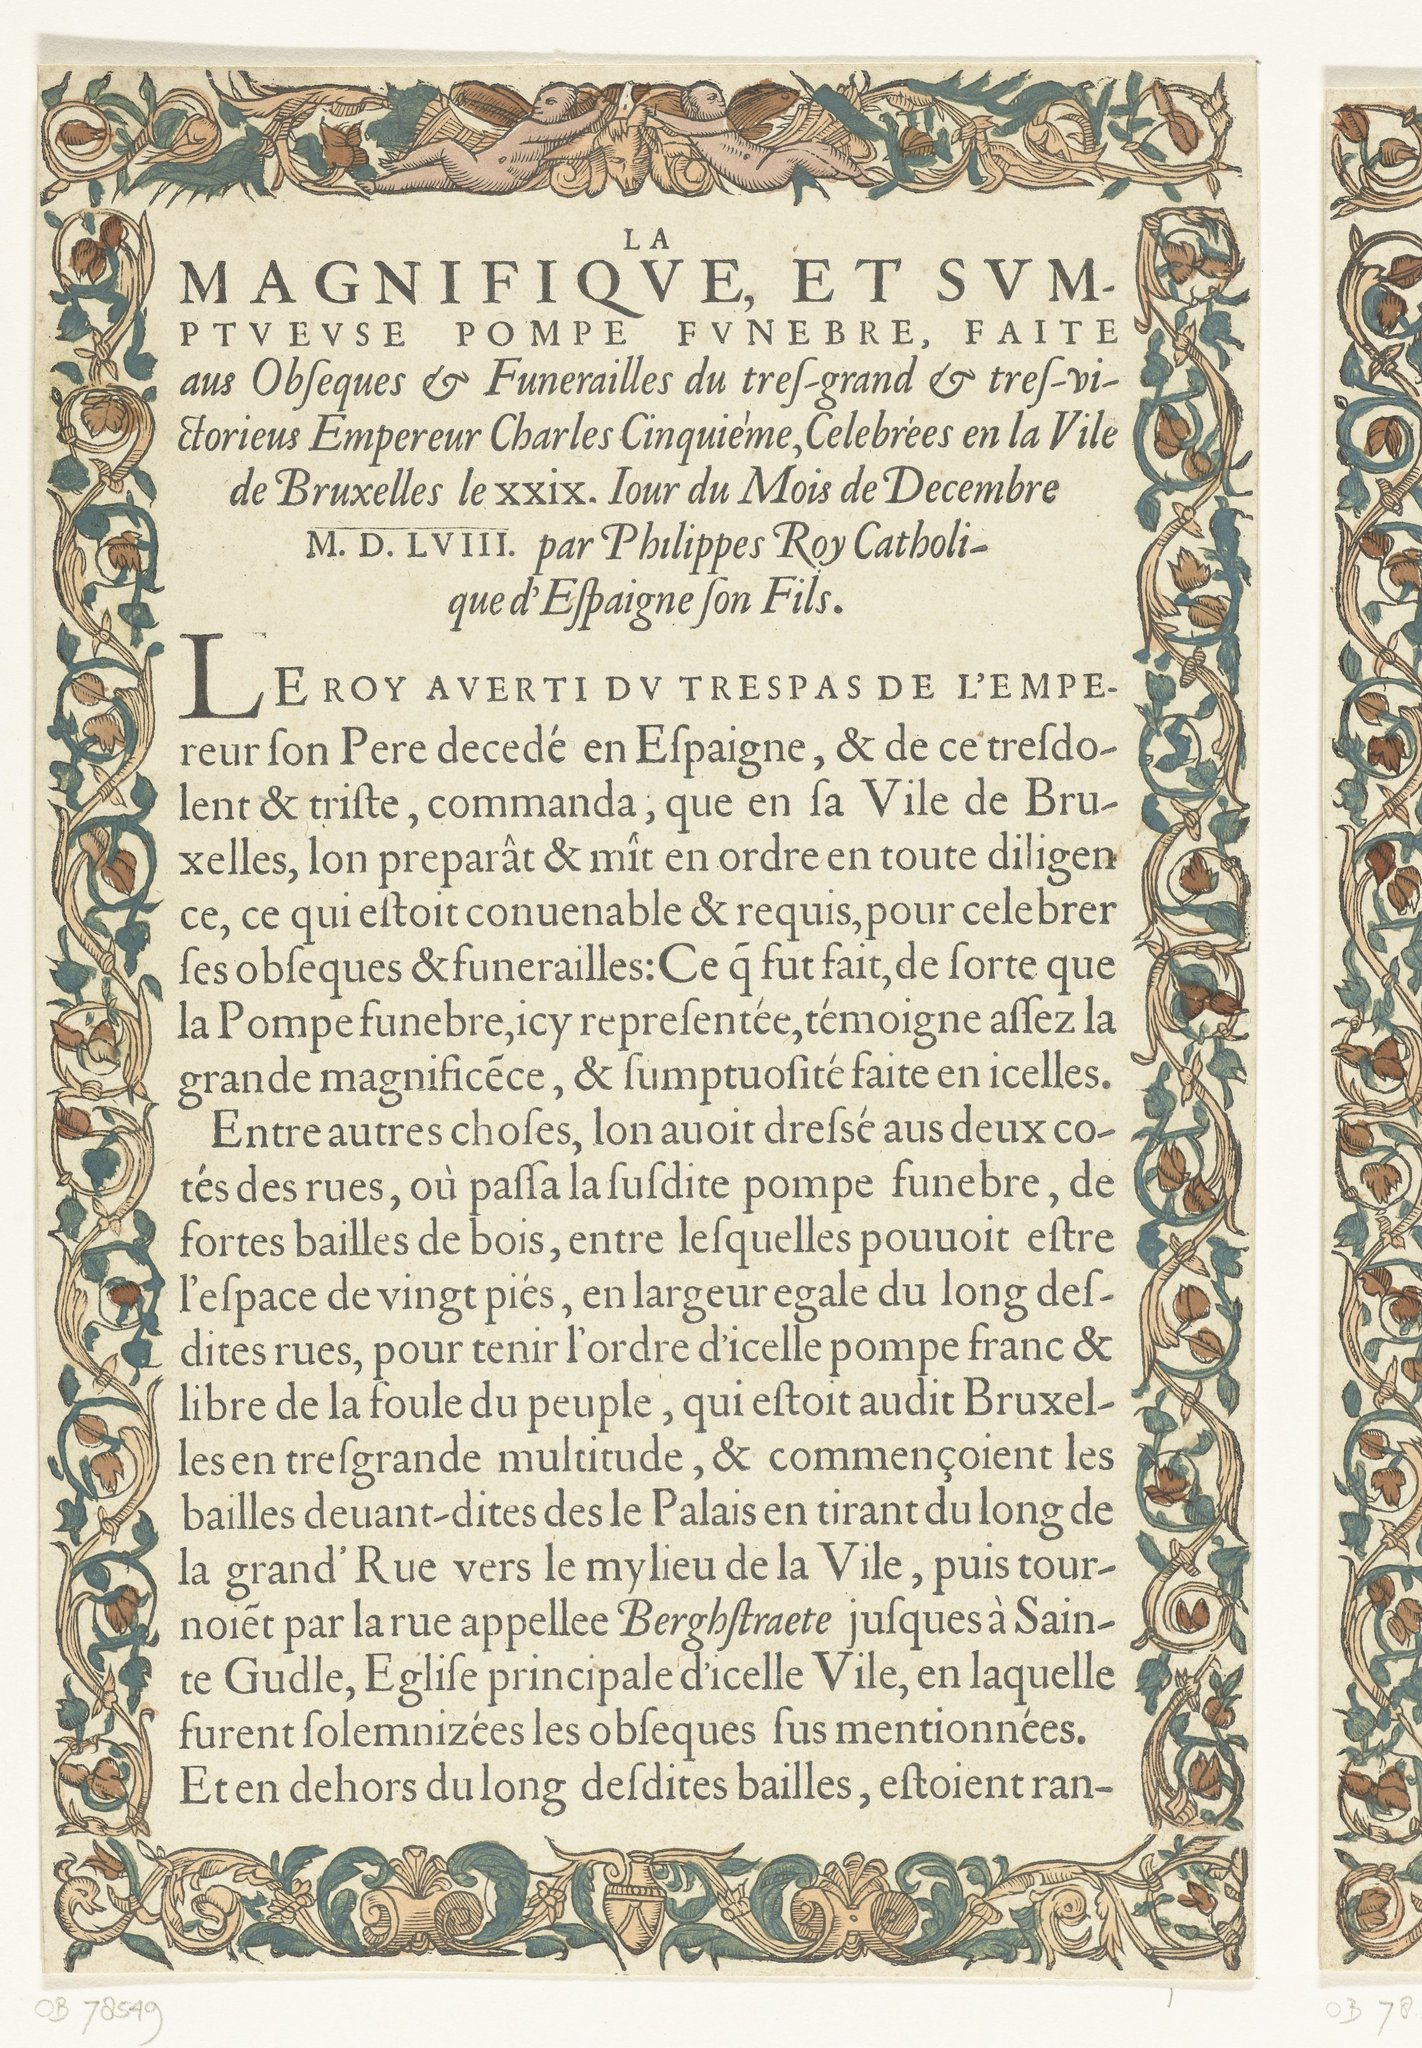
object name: text sheet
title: Begrafenisoptocht van keizer Karel V, 1558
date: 1559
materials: paper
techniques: hand coloring, letterpress printing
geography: antwerp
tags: ghent, charles v (holy roman emperor and king of spain), brussels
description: Tekstblad bij de Begrafenisoptocht van keizer Karel V, 1558. Tekstblad met titel en beschrijving van de optocht. In ornamentele randen in houtsnede. Eerste blad.